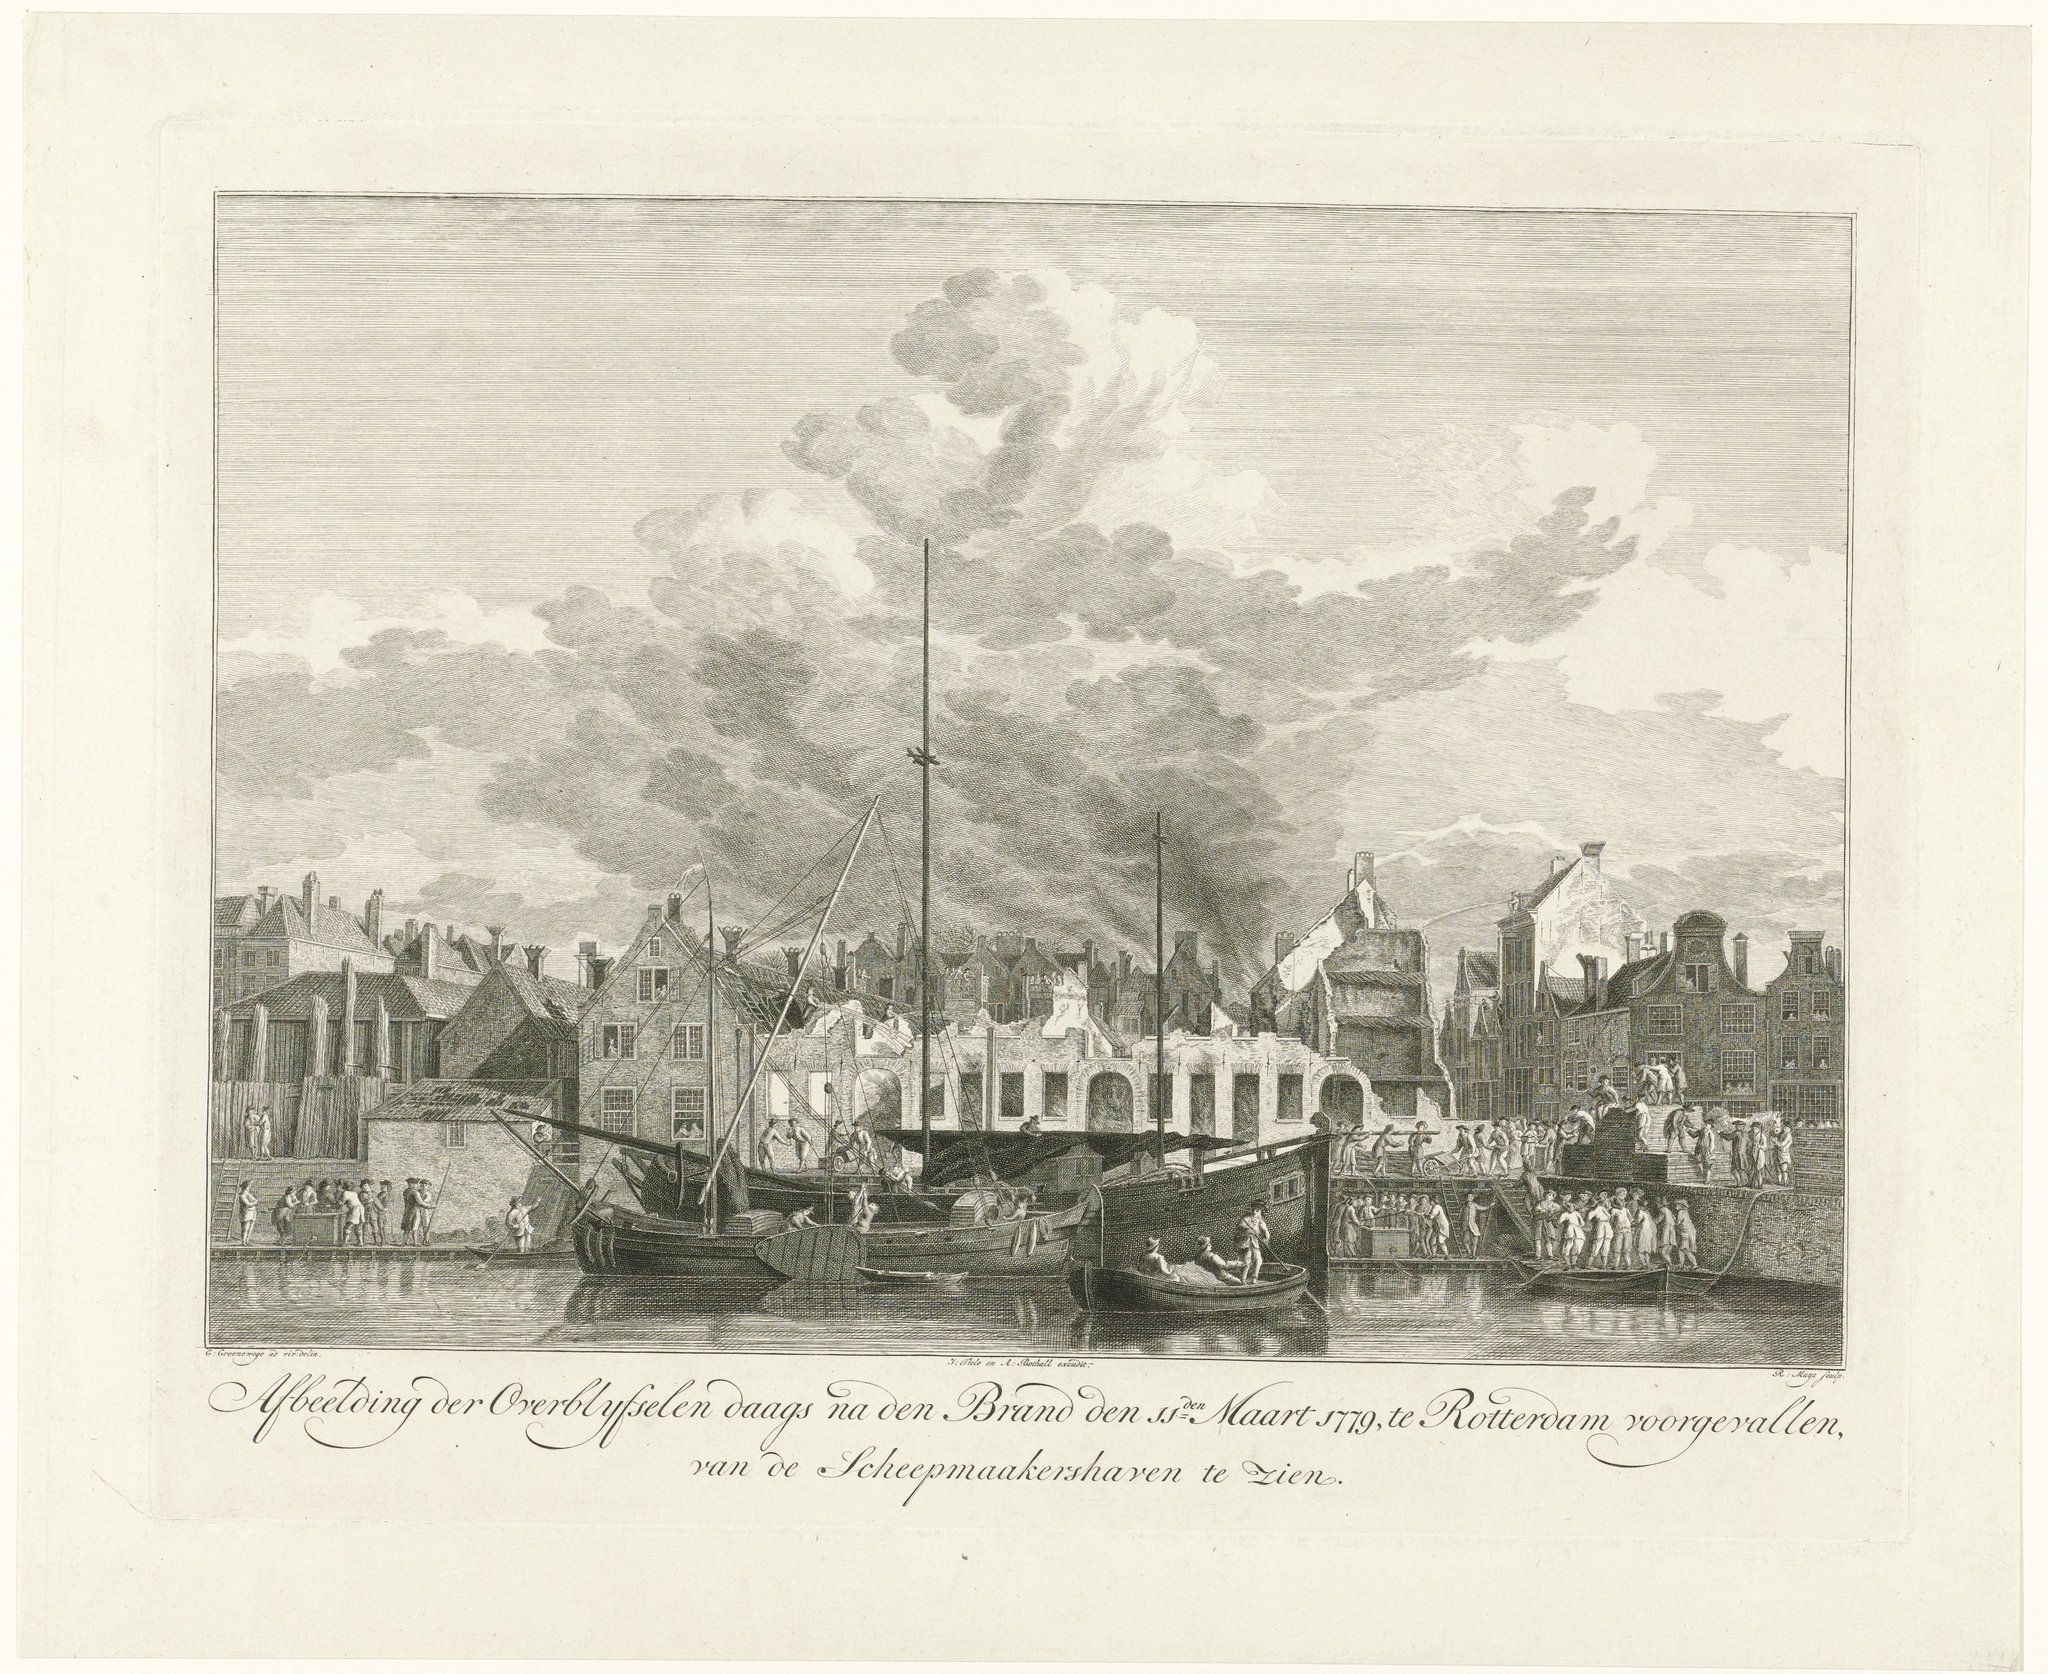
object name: print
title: Ruïnes na de brand in de Pottebakkerssteeg te Rotterdam, 1779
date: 1779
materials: paper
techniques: engraving, etching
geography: rotterdam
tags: fire-fighting, rotterdam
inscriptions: collector's mark: Lugt 2228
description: Gezicht op de ruïnes van de gebouwen daags na de grote brand in enkele huizen in de Pottebakkerssteeg te Rotterdam, 11 maart 1779. Er wordt nog nageblust door brandweerlieden. Op de voorgrond boten in het water van de Scheepmakershaven.